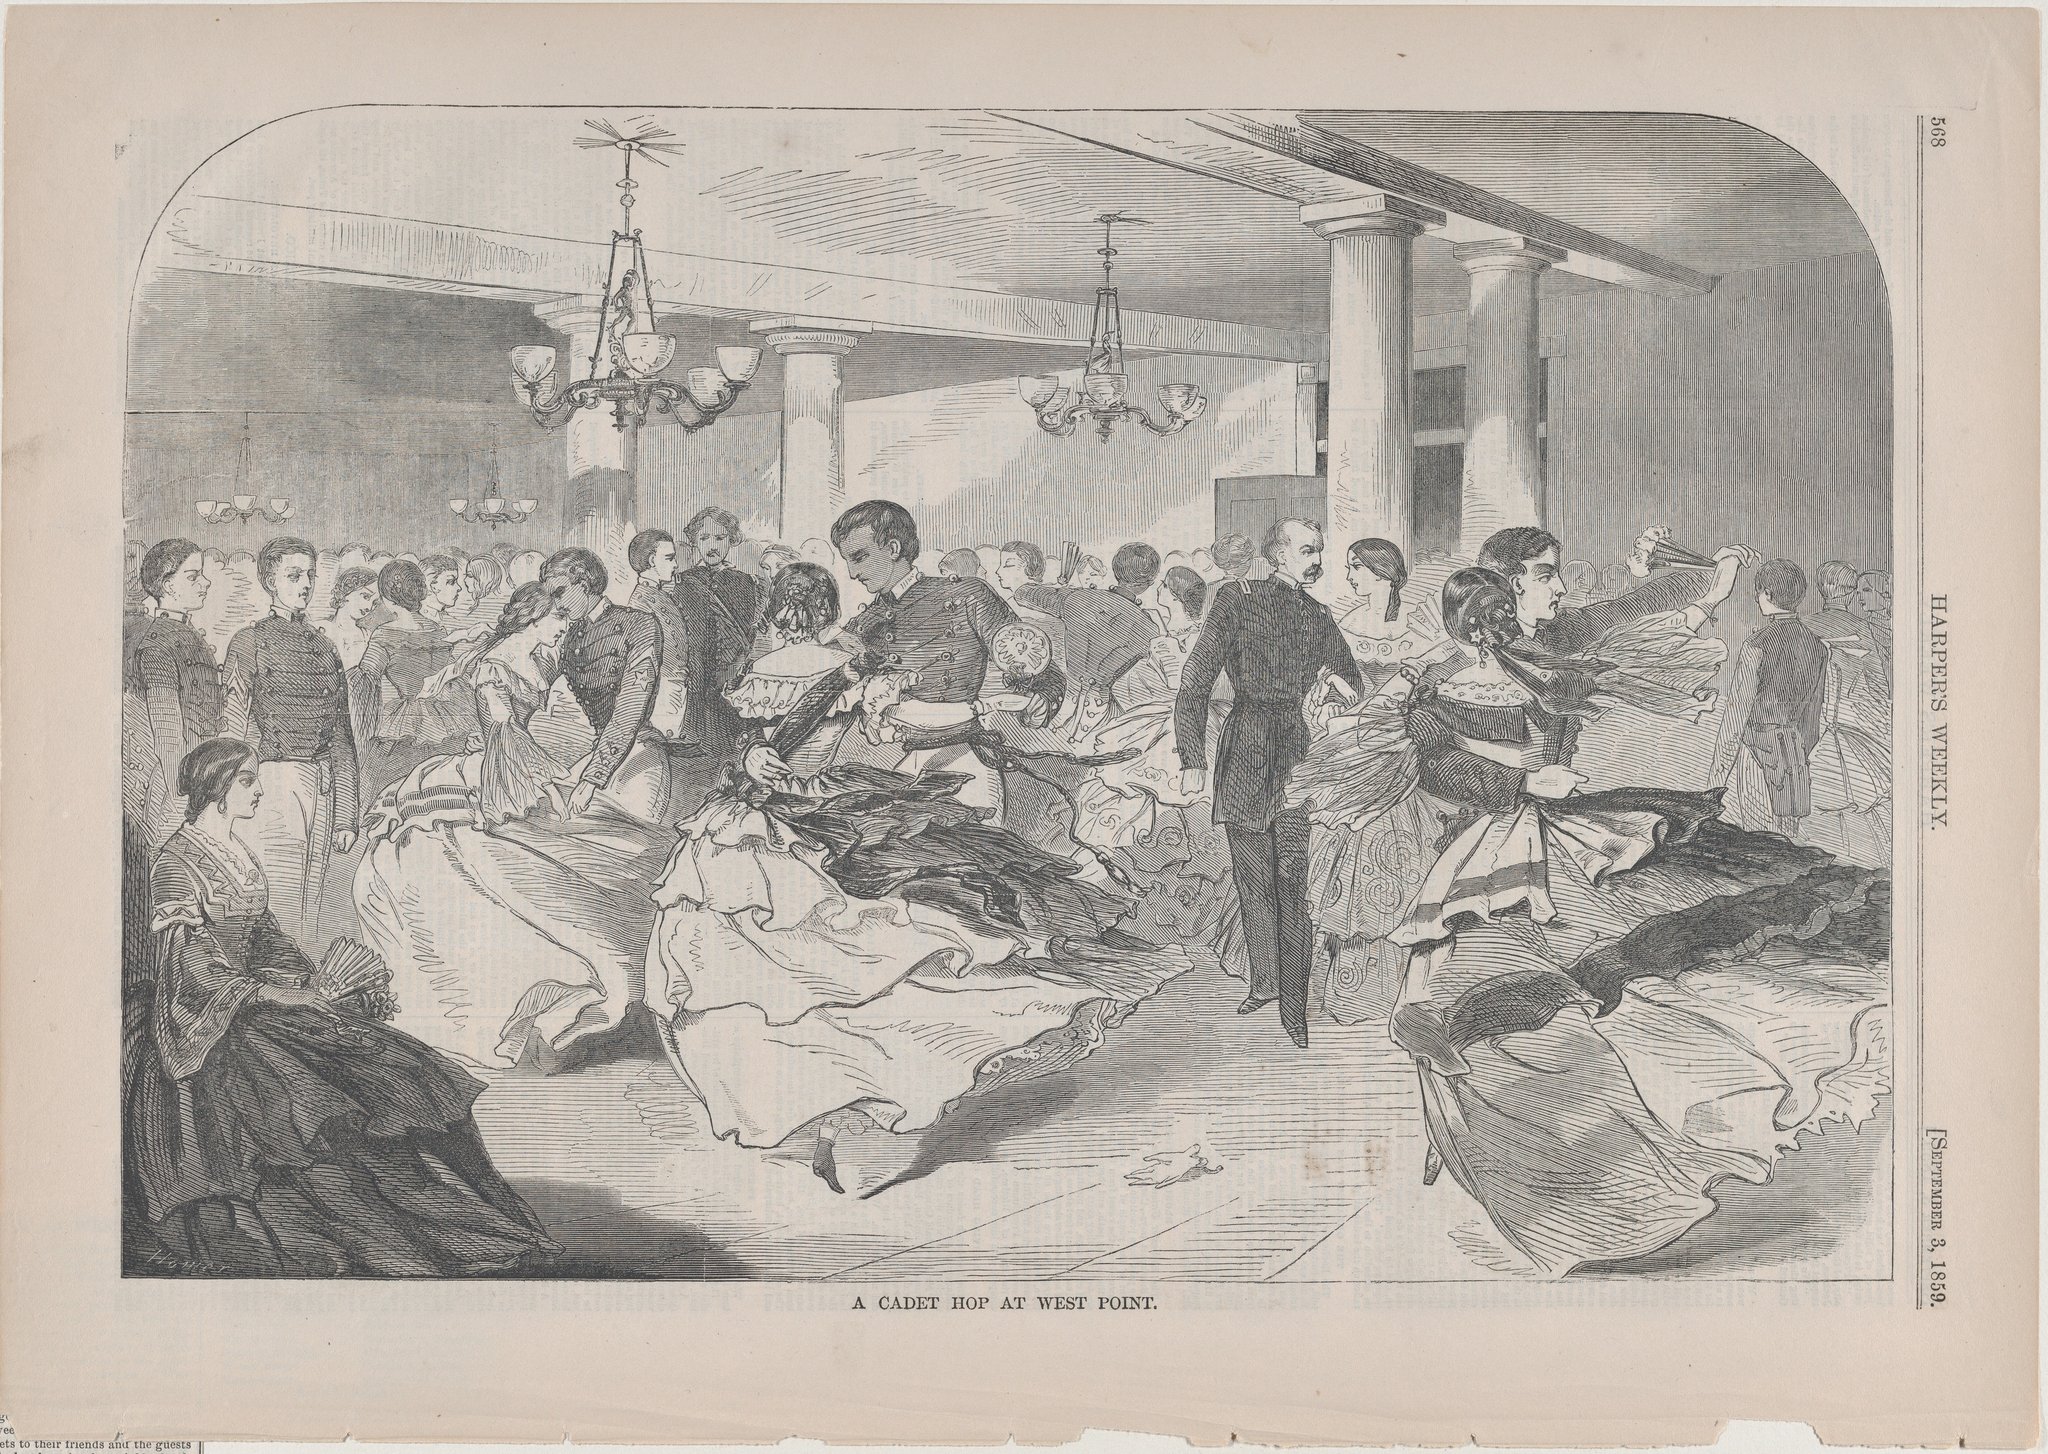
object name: print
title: A Cadet Hop at West Point (from "Harper's Weekly," Vol. III)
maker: winslow homer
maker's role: artist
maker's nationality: american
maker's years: 1836-1910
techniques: engraving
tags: dance,men,women